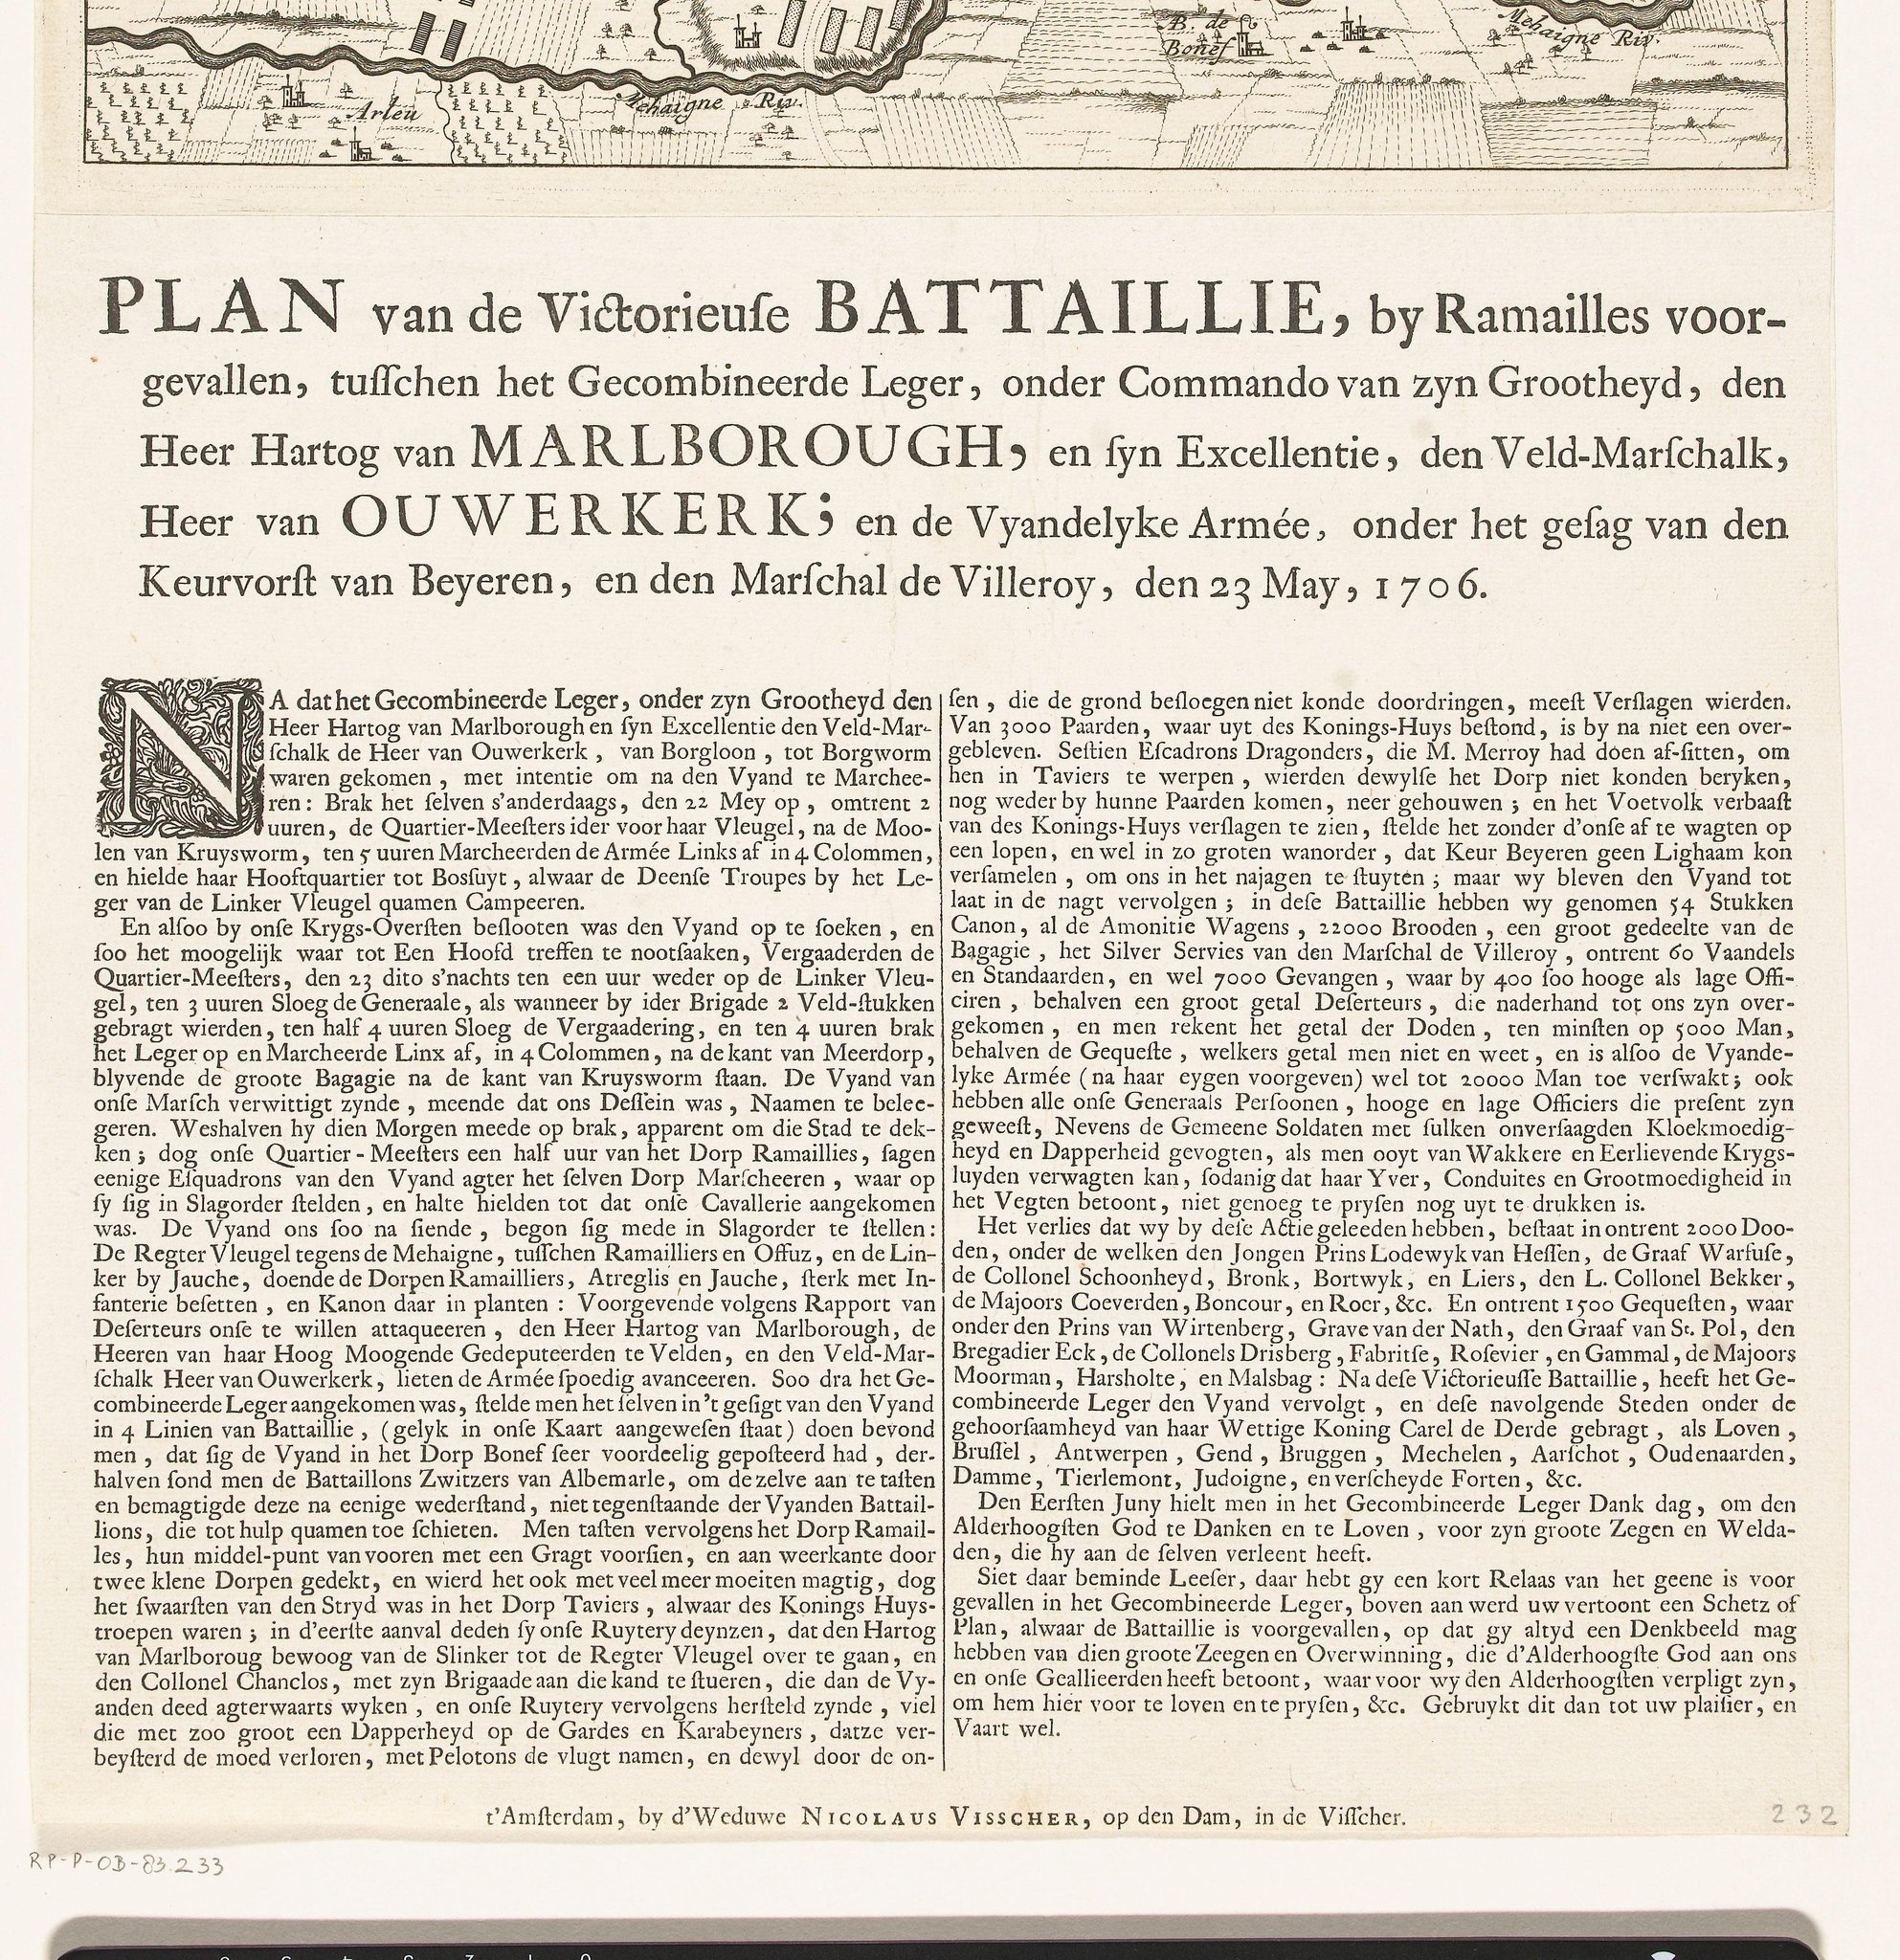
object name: print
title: Plan van de Victorieuse Battaillie, by Ramailles voorgevallen, tusschen het Gecombineerde Leger, onder Commando van zyn Grootheyd, den Heer Hartog van Marlborough, en syn Excellentie, den Veld-Marschalk, Heer van Ouwerkerk; en de Vyandelyke Armée, onder het gesag van den Keurvorst van Beyeren, en den Marschal de Villeroy, den 23 May, 1706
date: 1706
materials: paper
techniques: etching, letterpress printing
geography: amsterdam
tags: lyon, paris, françois de neufville (hertog van villeroy), maximiliaan ii emanuel (keurvorst van beieren), john churchill (1e hertog van marlborough), the hague, maps of separate countries or regions, battle (+ land forces)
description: Kaart van de slag bij Ramillies tussen de Geallieerden onder de hertog van Marlborough en de Heer van Ouwerkerk en de Fransen en Spanjaarden onder de keurvorst van Beieren en de hertog van Villeroy, 23 mei 1706. Vastgeplakt onder de plaat een tekst in 2 kolommen in het Nederlands.